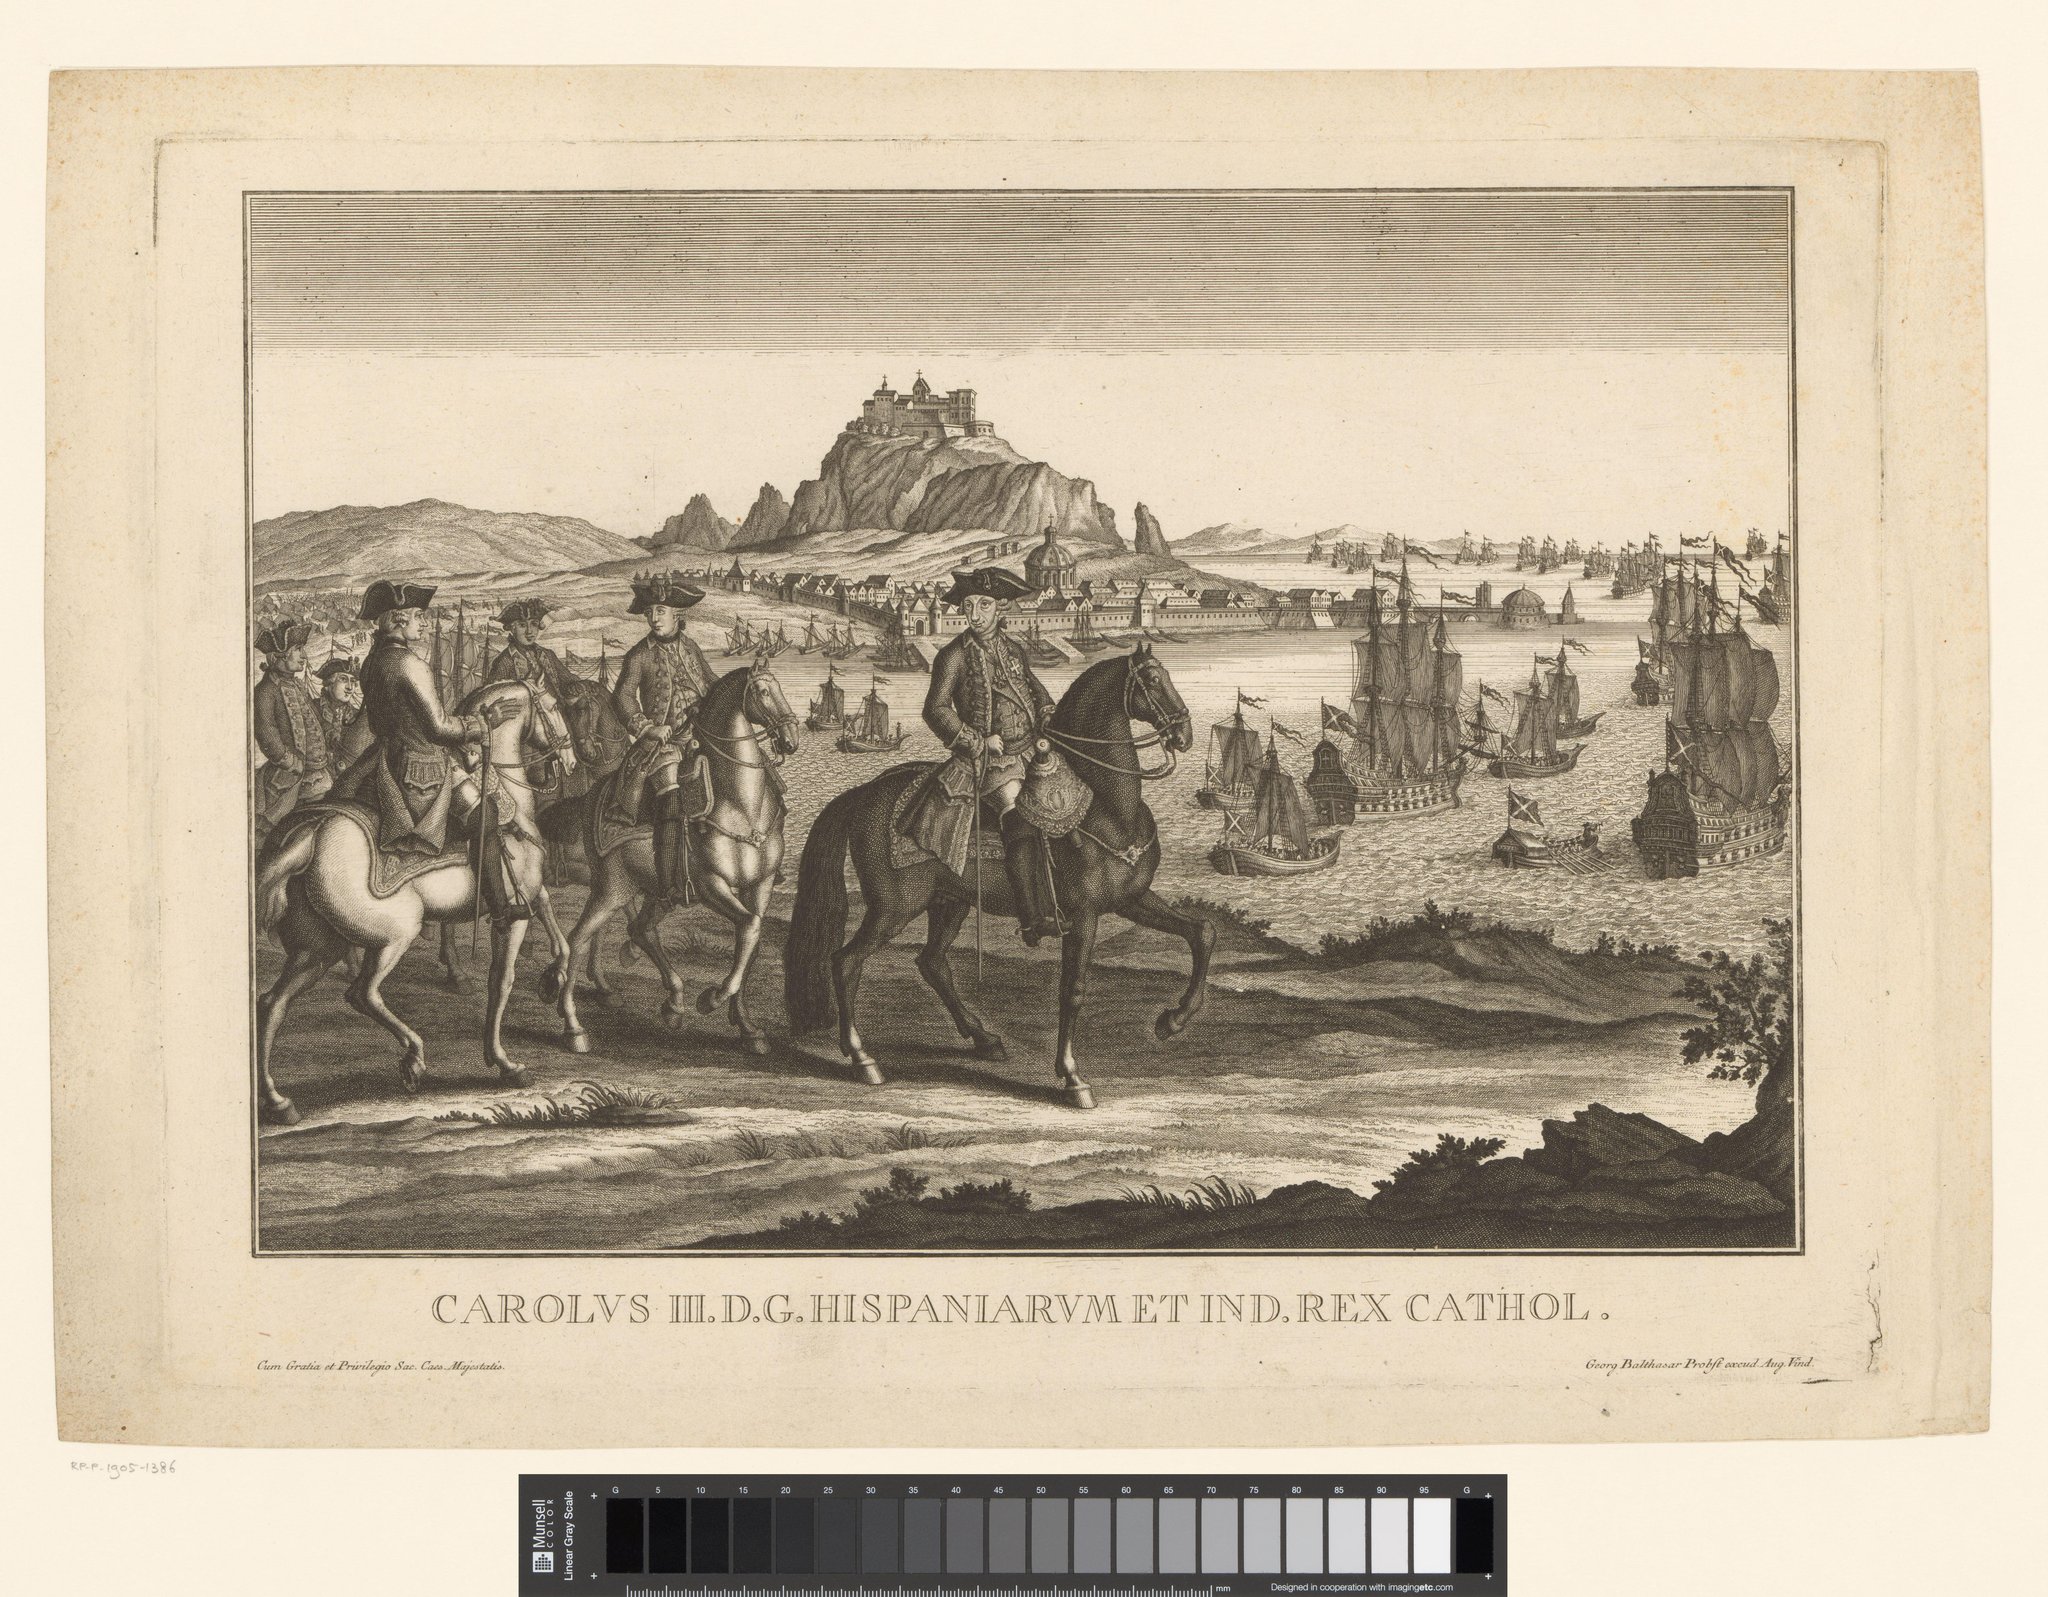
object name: print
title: Portret van Karel III, koning van Spanje te paard, met gevolg in landschap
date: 1759-1788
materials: paper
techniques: engraving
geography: augsburg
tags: karel iii (koning van spanje (1716-1788), harbour, equestrian state-portrait, riding a horse, ass, or mule; rider, horseman, city-view, and landscape with man-made constructions, ships (in general) - cc - more than one ship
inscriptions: collector's mark: Lugt 2228